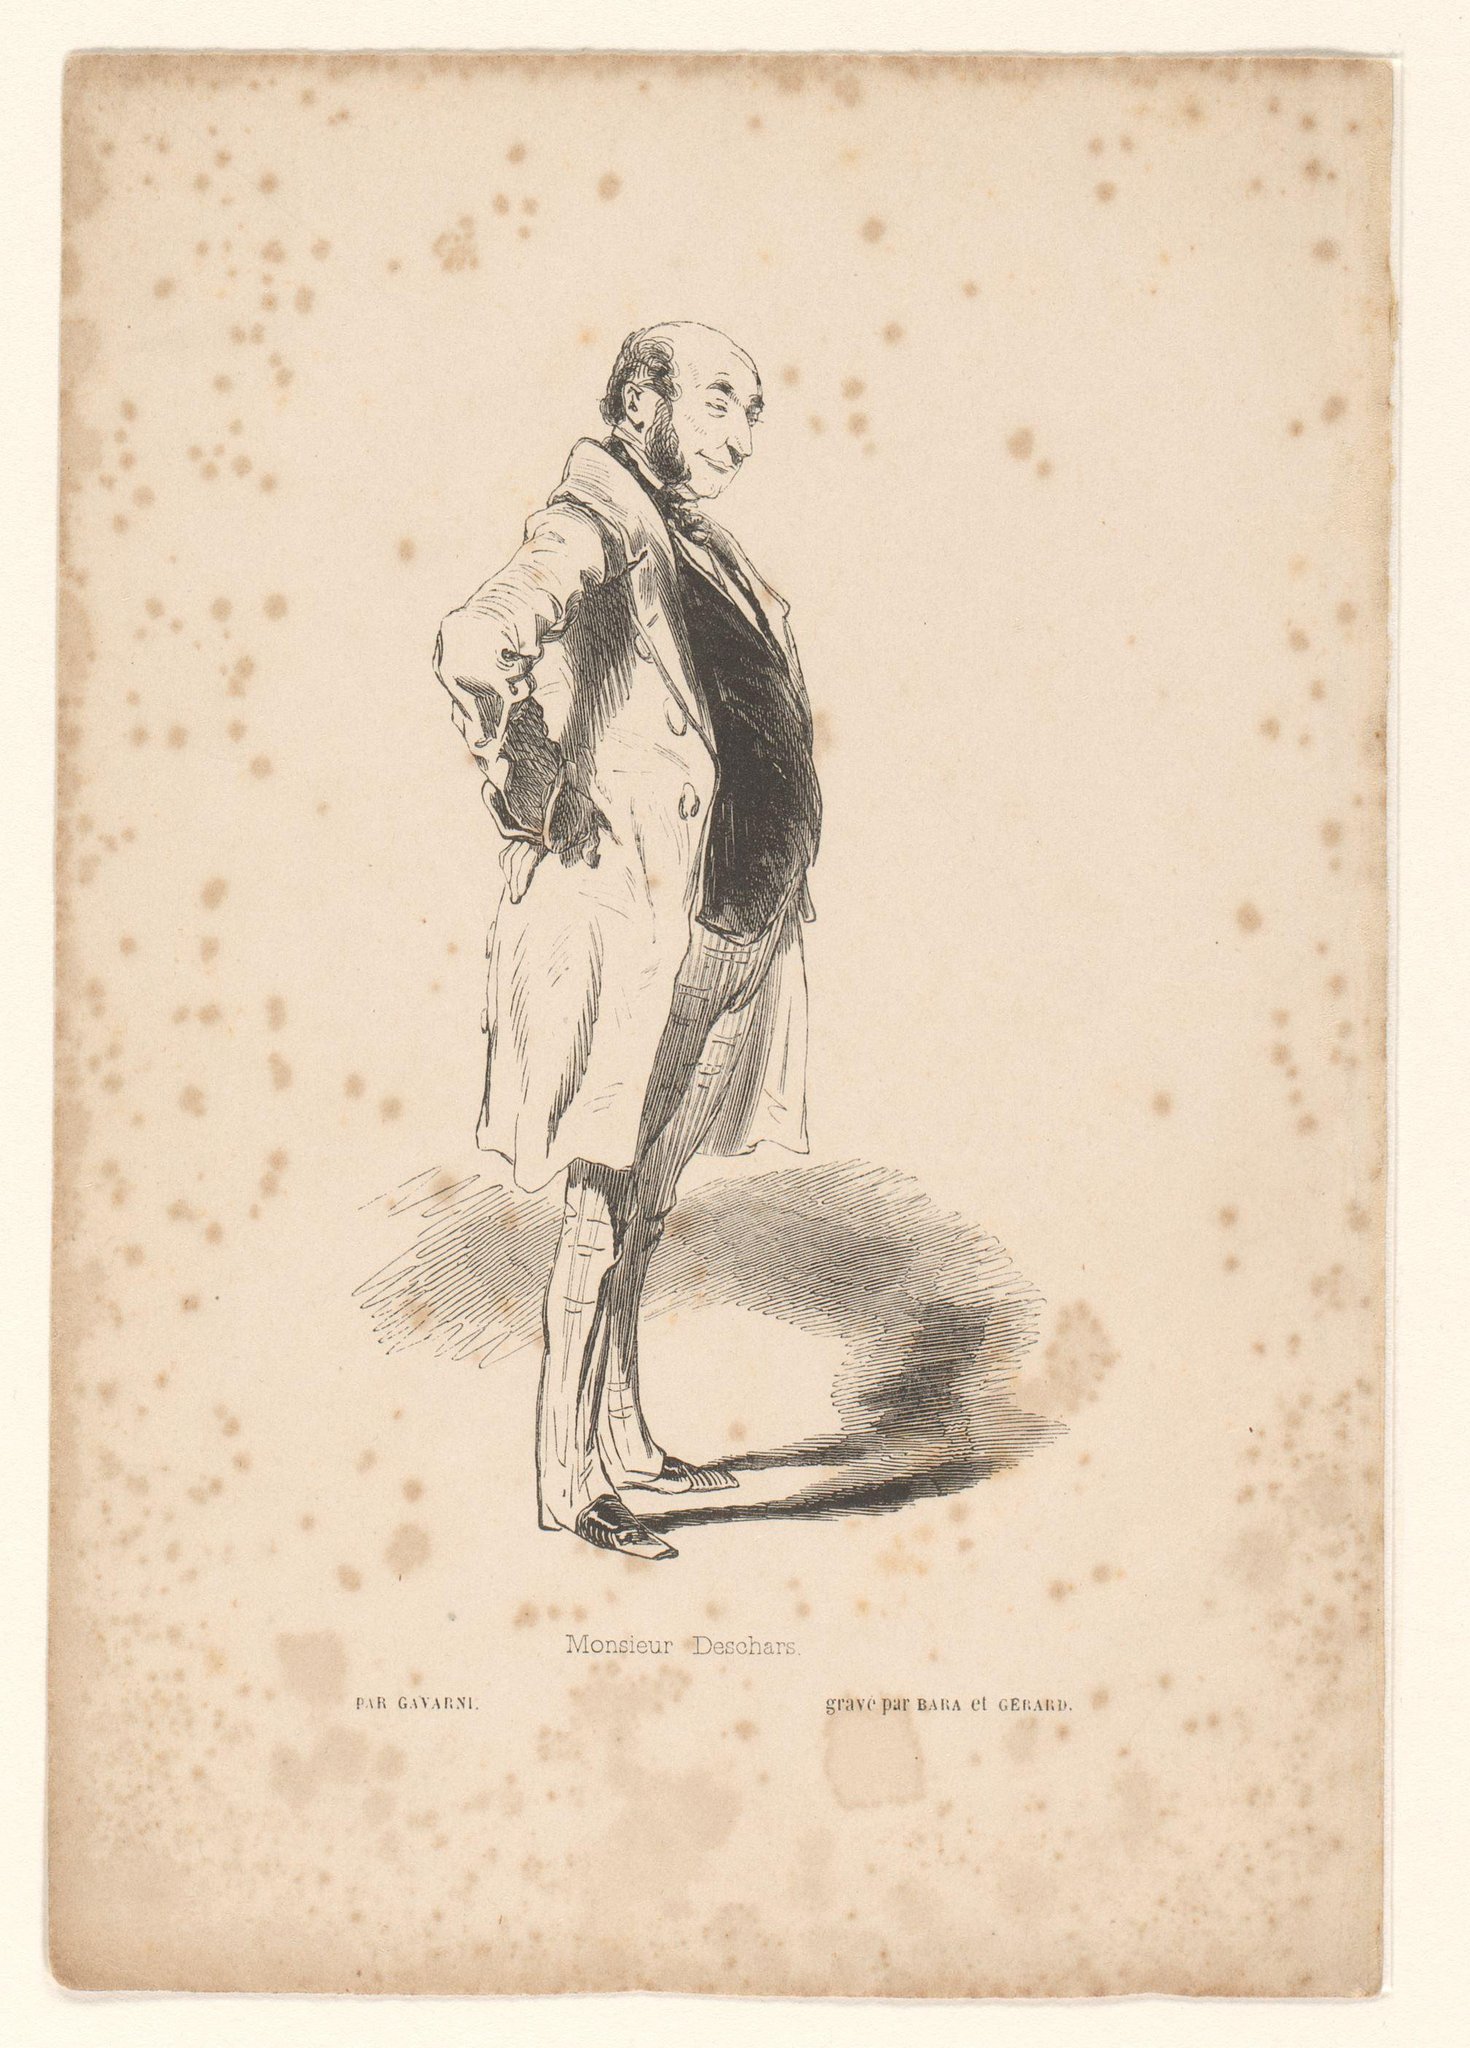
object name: print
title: Monsieur Deschars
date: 1830-1862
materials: paper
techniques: engraving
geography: france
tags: honoré de balzac, names of literary characters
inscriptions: signature: ‘Gravé par Bara et Gérard’